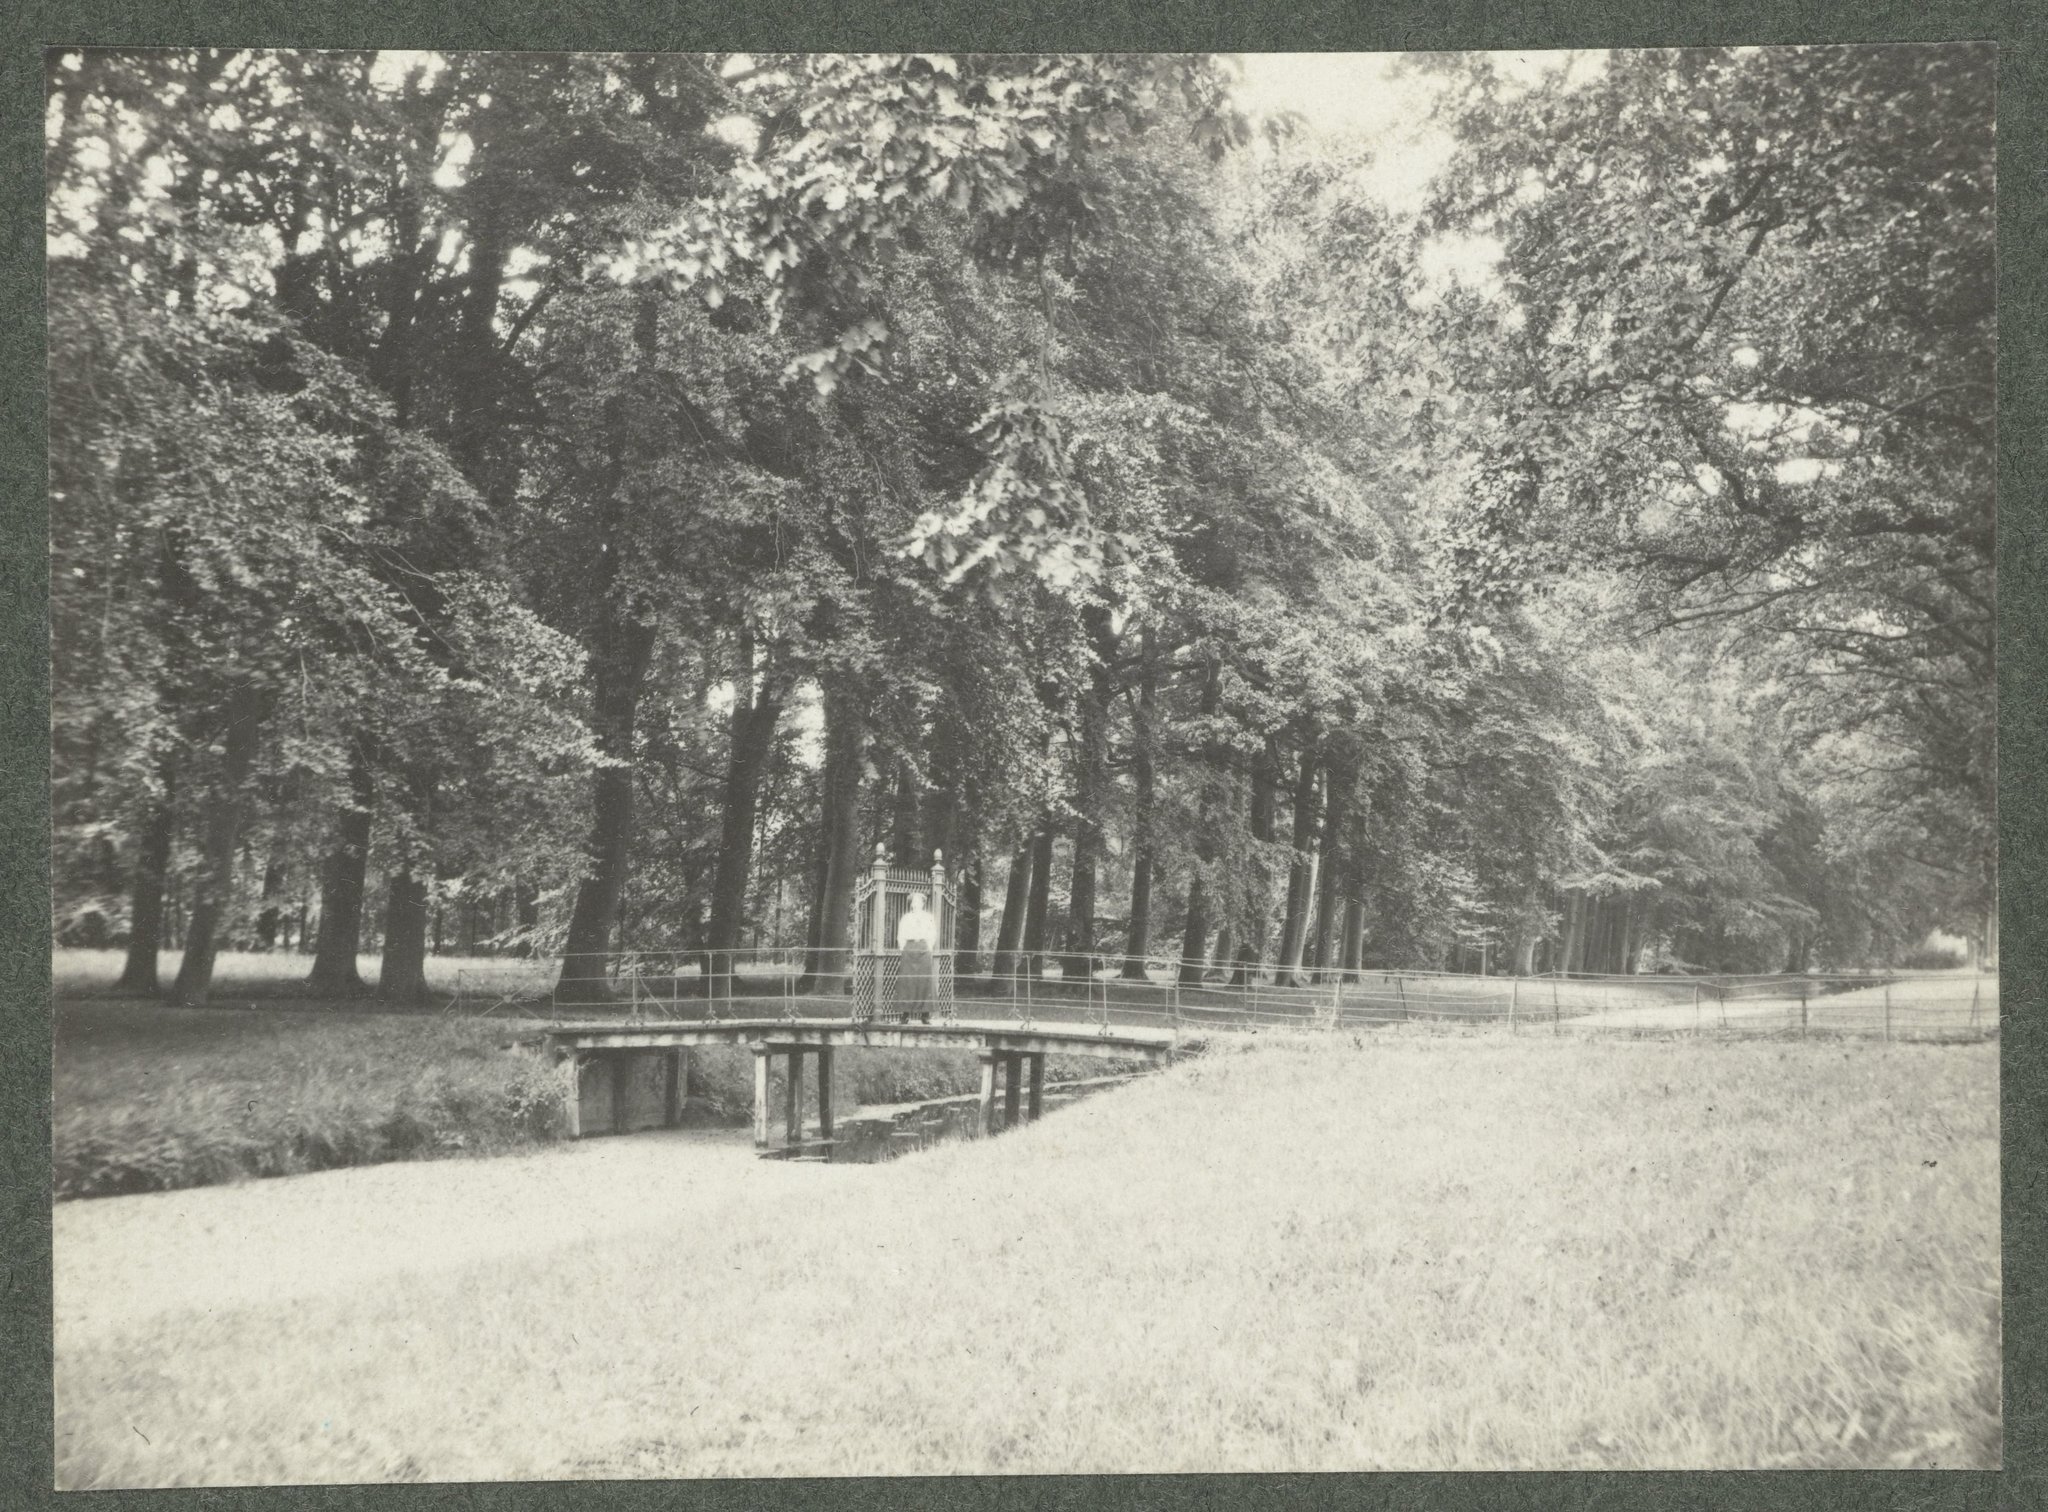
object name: photograph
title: Vrouw op een brug in de tuin van Landgoed De Paauw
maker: geldolph adriaan kessler (dolph)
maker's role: fotograaf, industrieel, voetballer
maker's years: 1884-1945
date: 1913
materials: paper, photographic support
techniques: photography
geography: netherlands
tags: huize de paauw